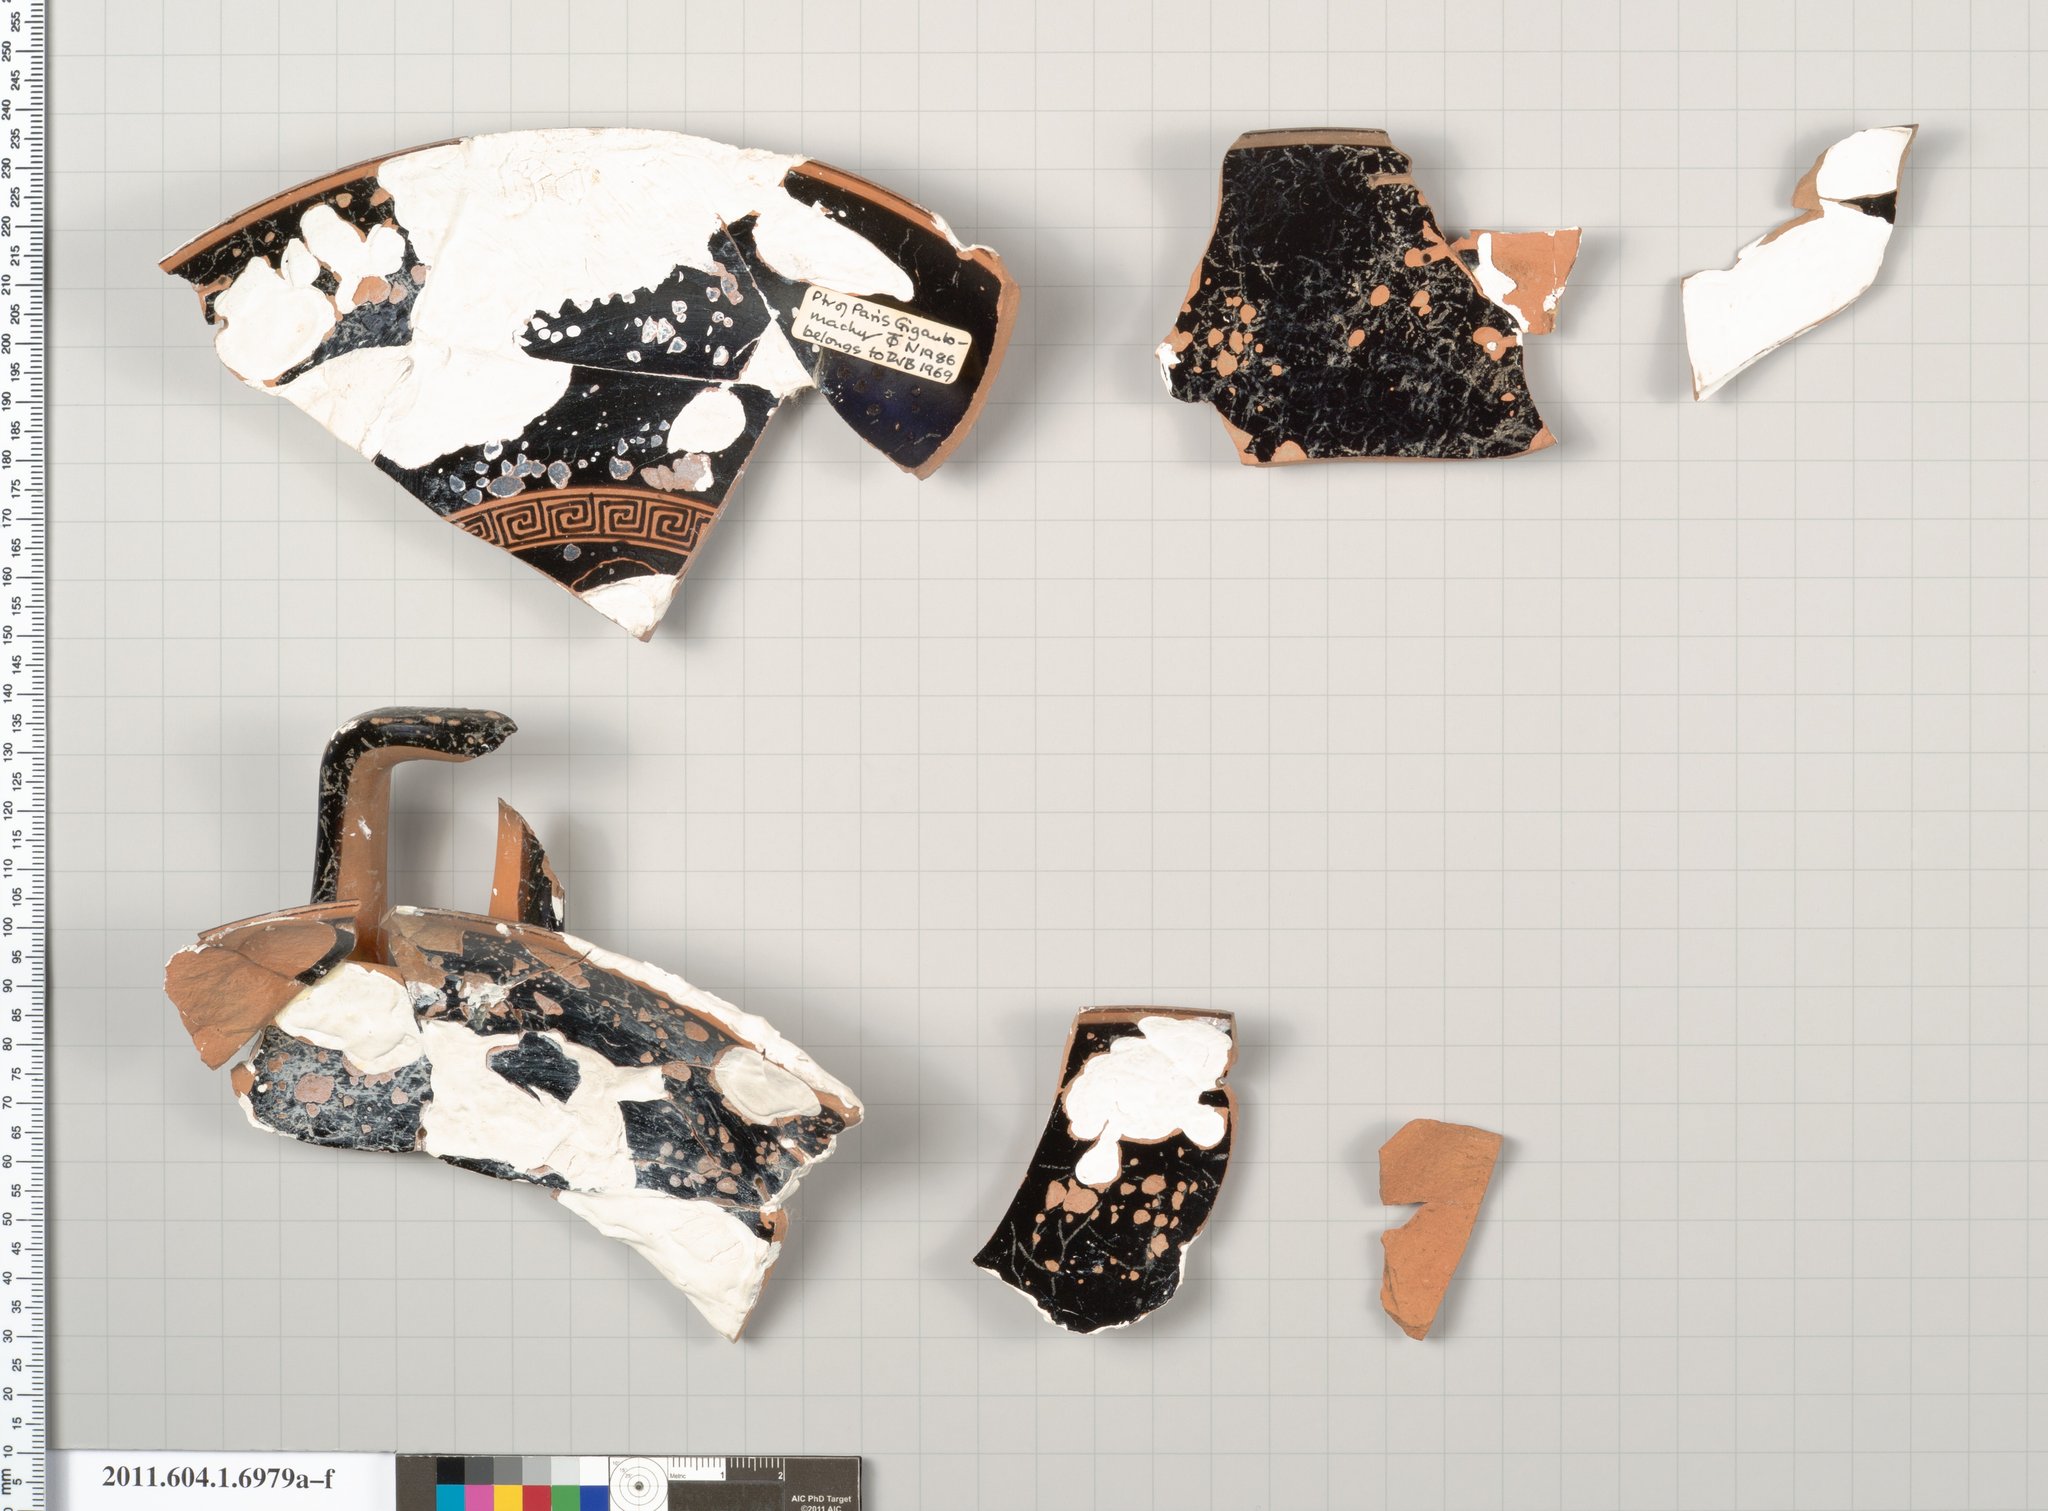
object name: kylix fragment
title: Terracotta fragments of a kylix (drinking cup)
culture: greek, attic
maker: painter of the paris gigantomachy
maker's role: artist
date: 480-470 BCE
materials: terracotta